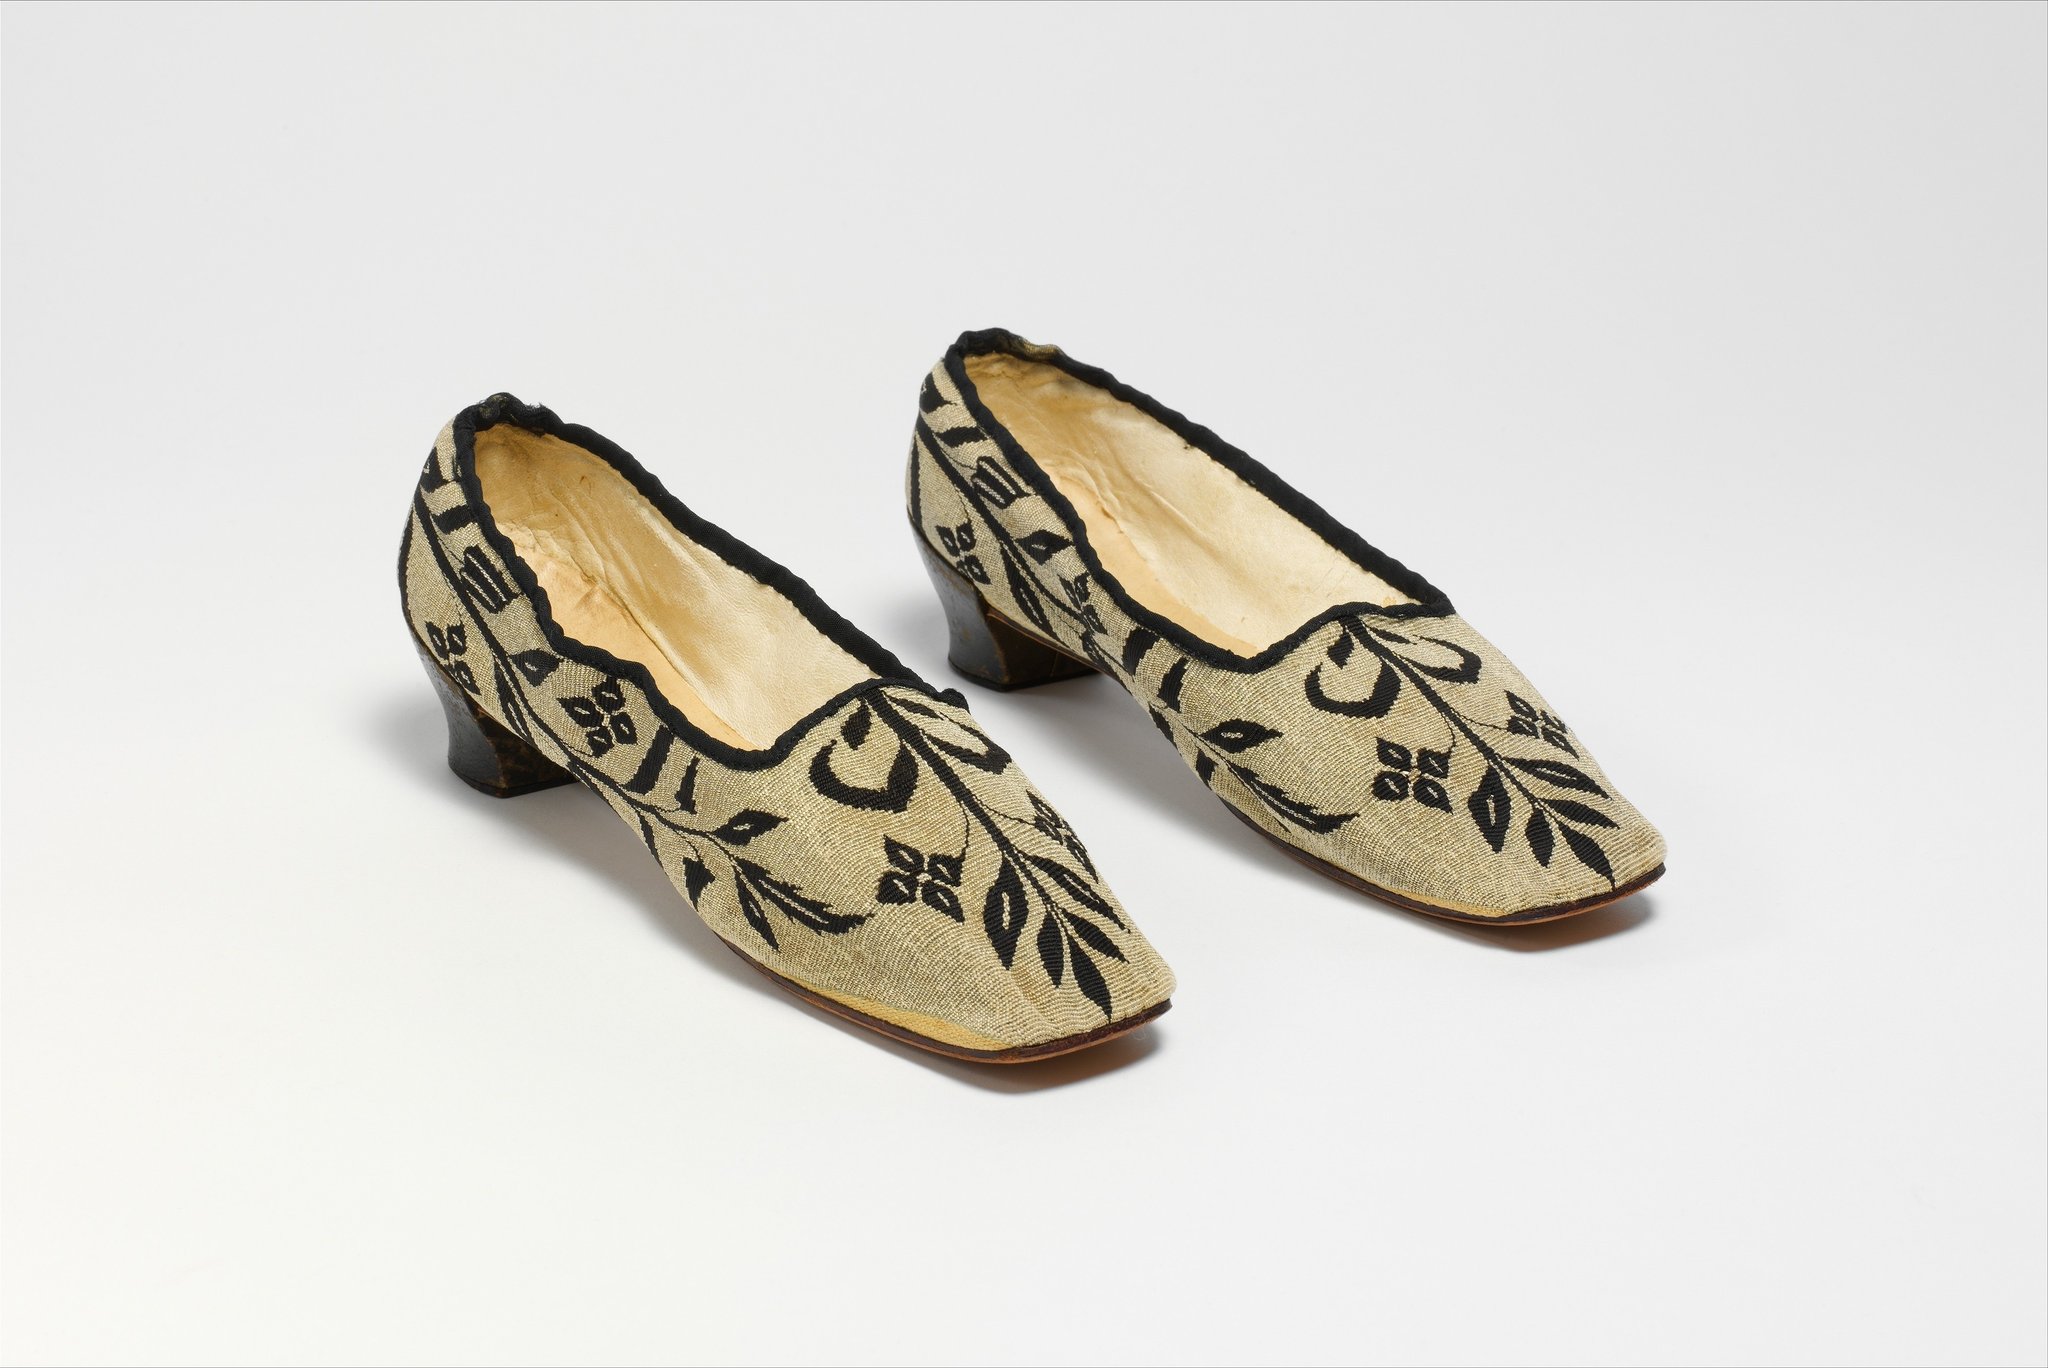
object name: shoe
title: Shoes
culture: american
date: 1854-1860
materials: leather, linen, silk, wool